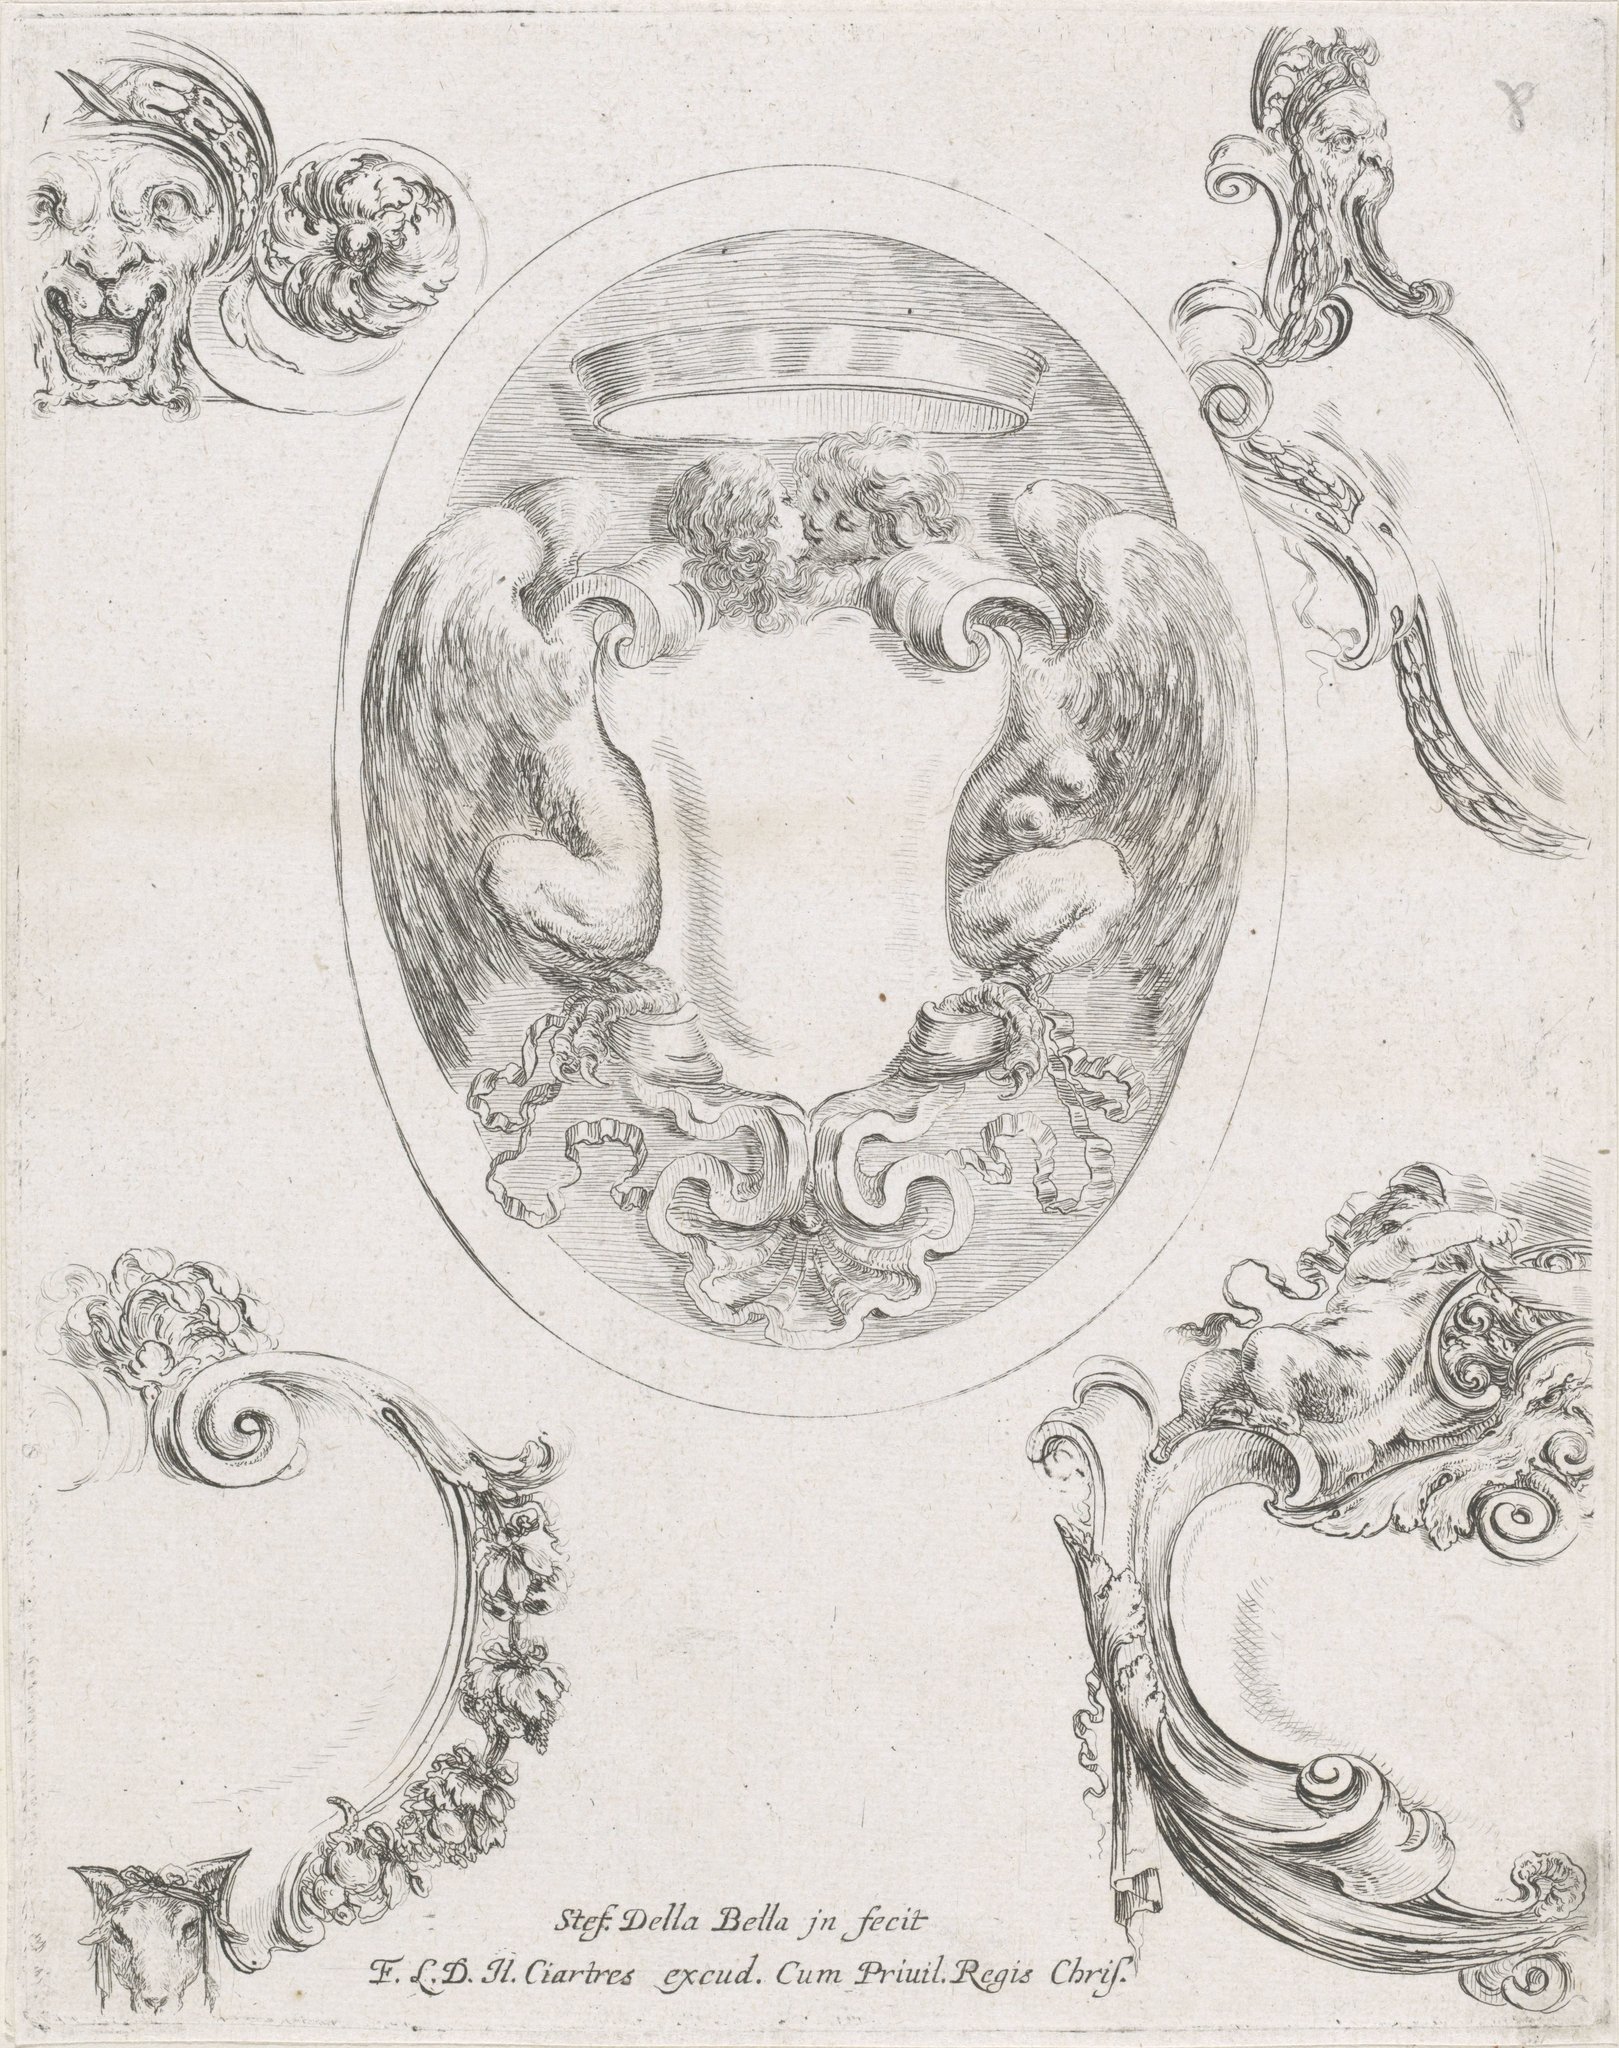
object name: print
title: Cartouches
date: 1646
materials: paper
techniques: etching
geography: france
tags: ornament ~ cartouche, harpy (fabulous bird); 'arpie' (ripa)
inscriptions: collector's mark: Lugt 240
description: Een cartouche met twee kussende harpijen onder een kroon. In de hoeken delen van cartouches en een masker.